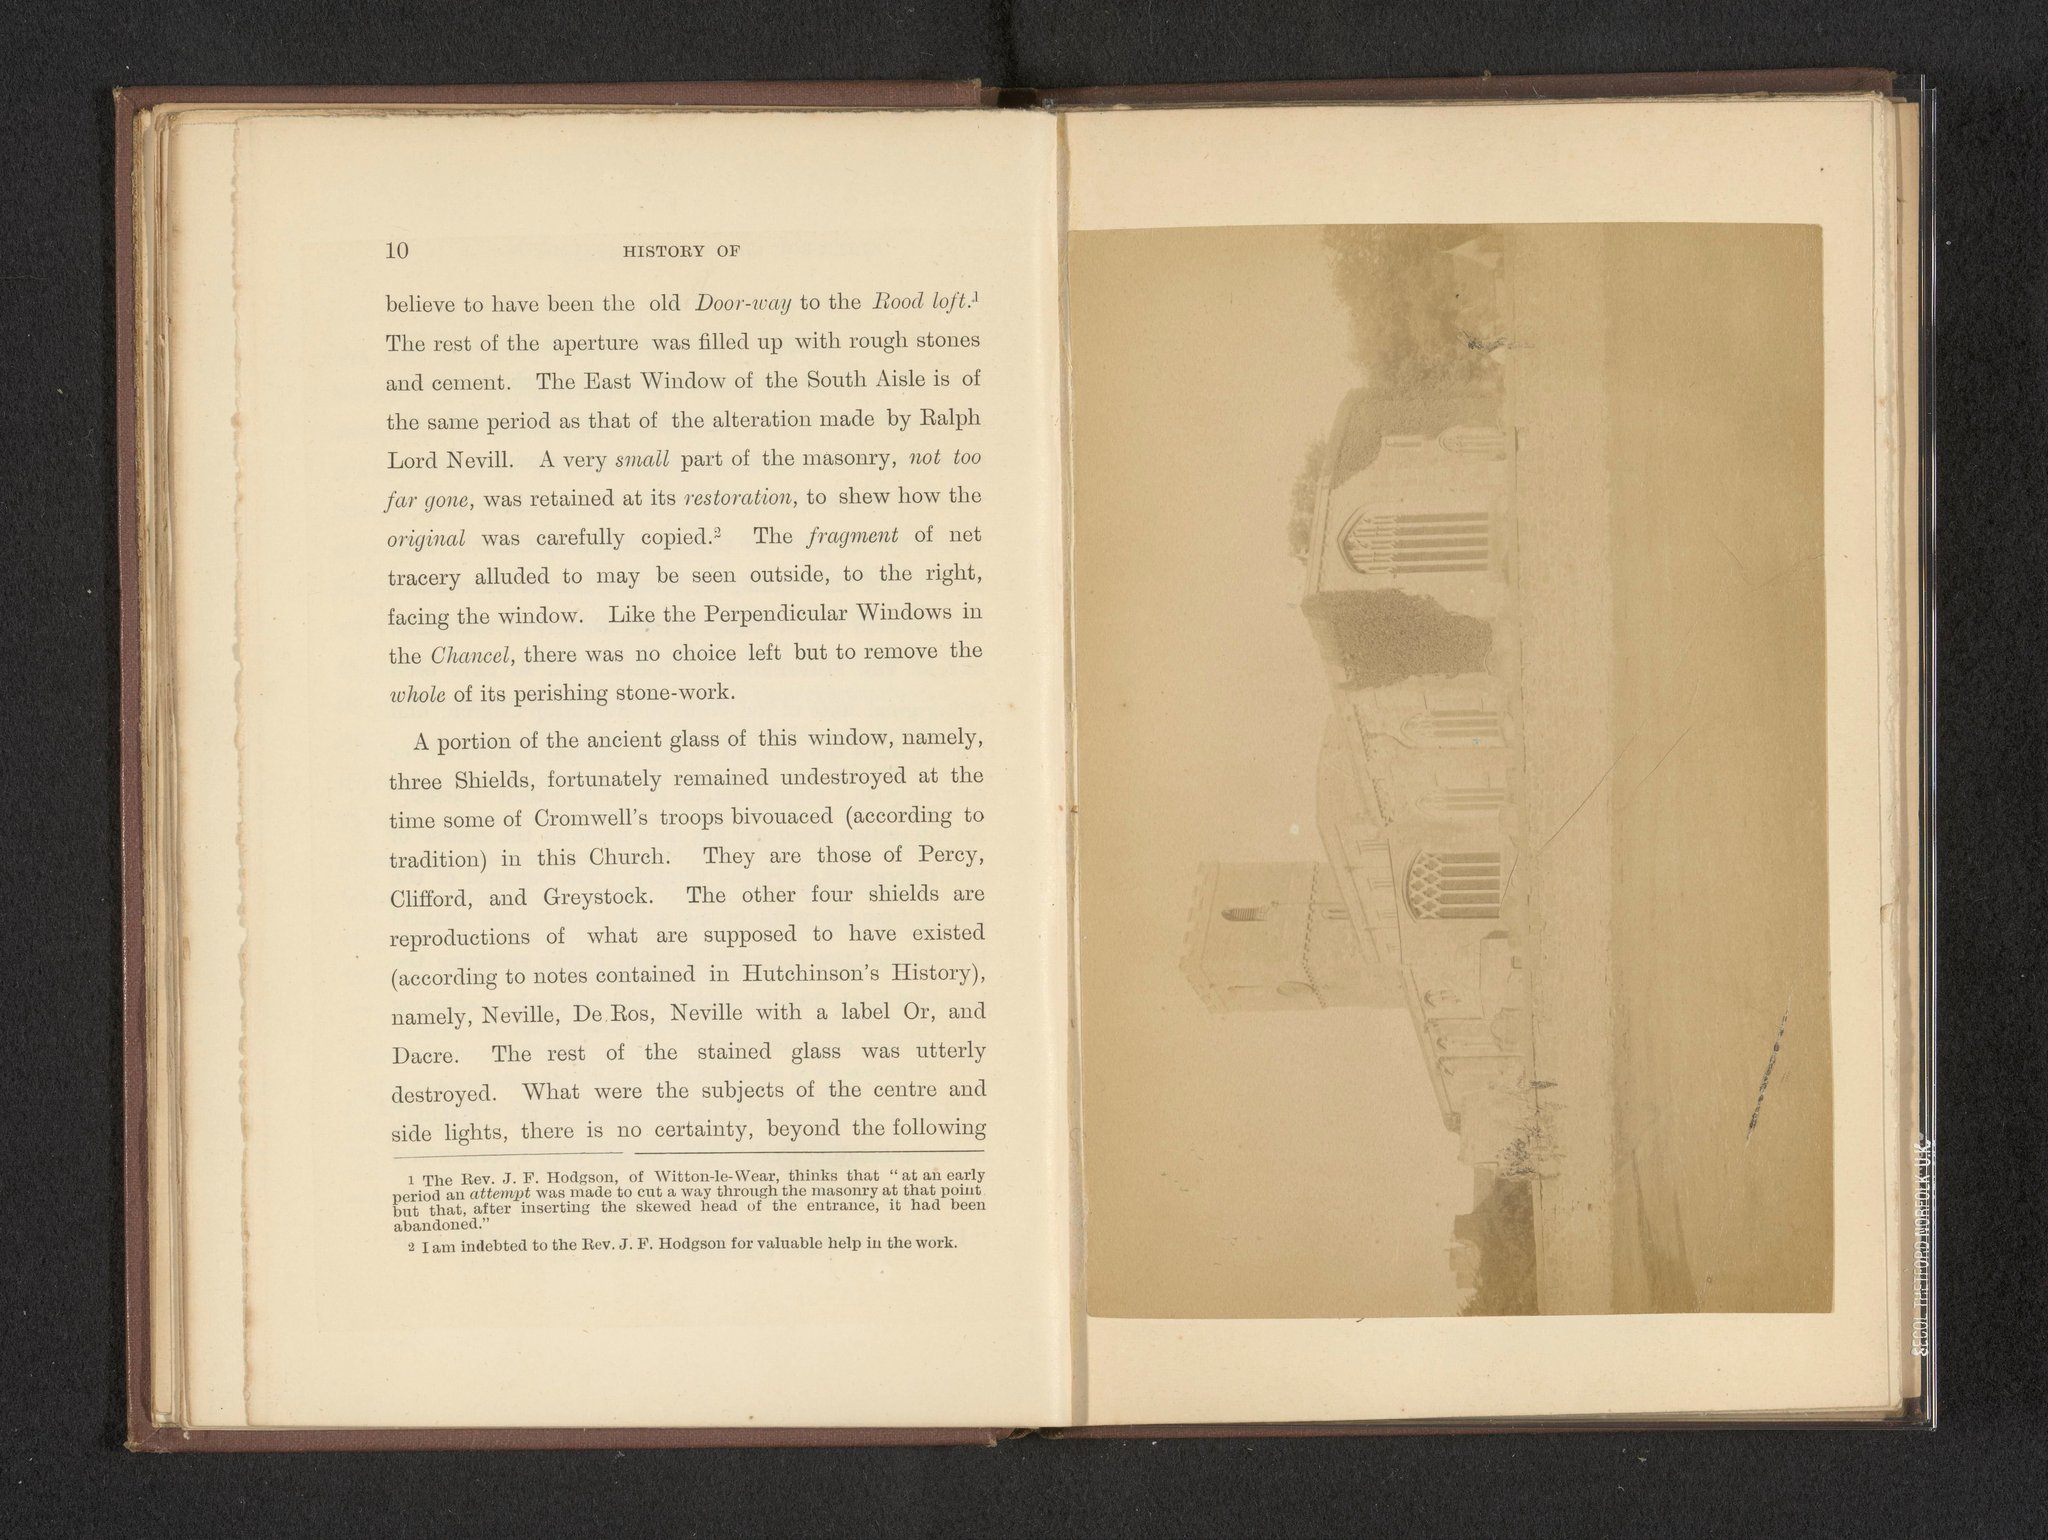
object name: photograph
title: Exterieur van Saint Mary's Church te Staindrop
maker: Anonymous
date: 1878-1888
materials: photographic support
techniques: albumen print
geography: staindrop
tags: church (exterior), façade (of house or building)